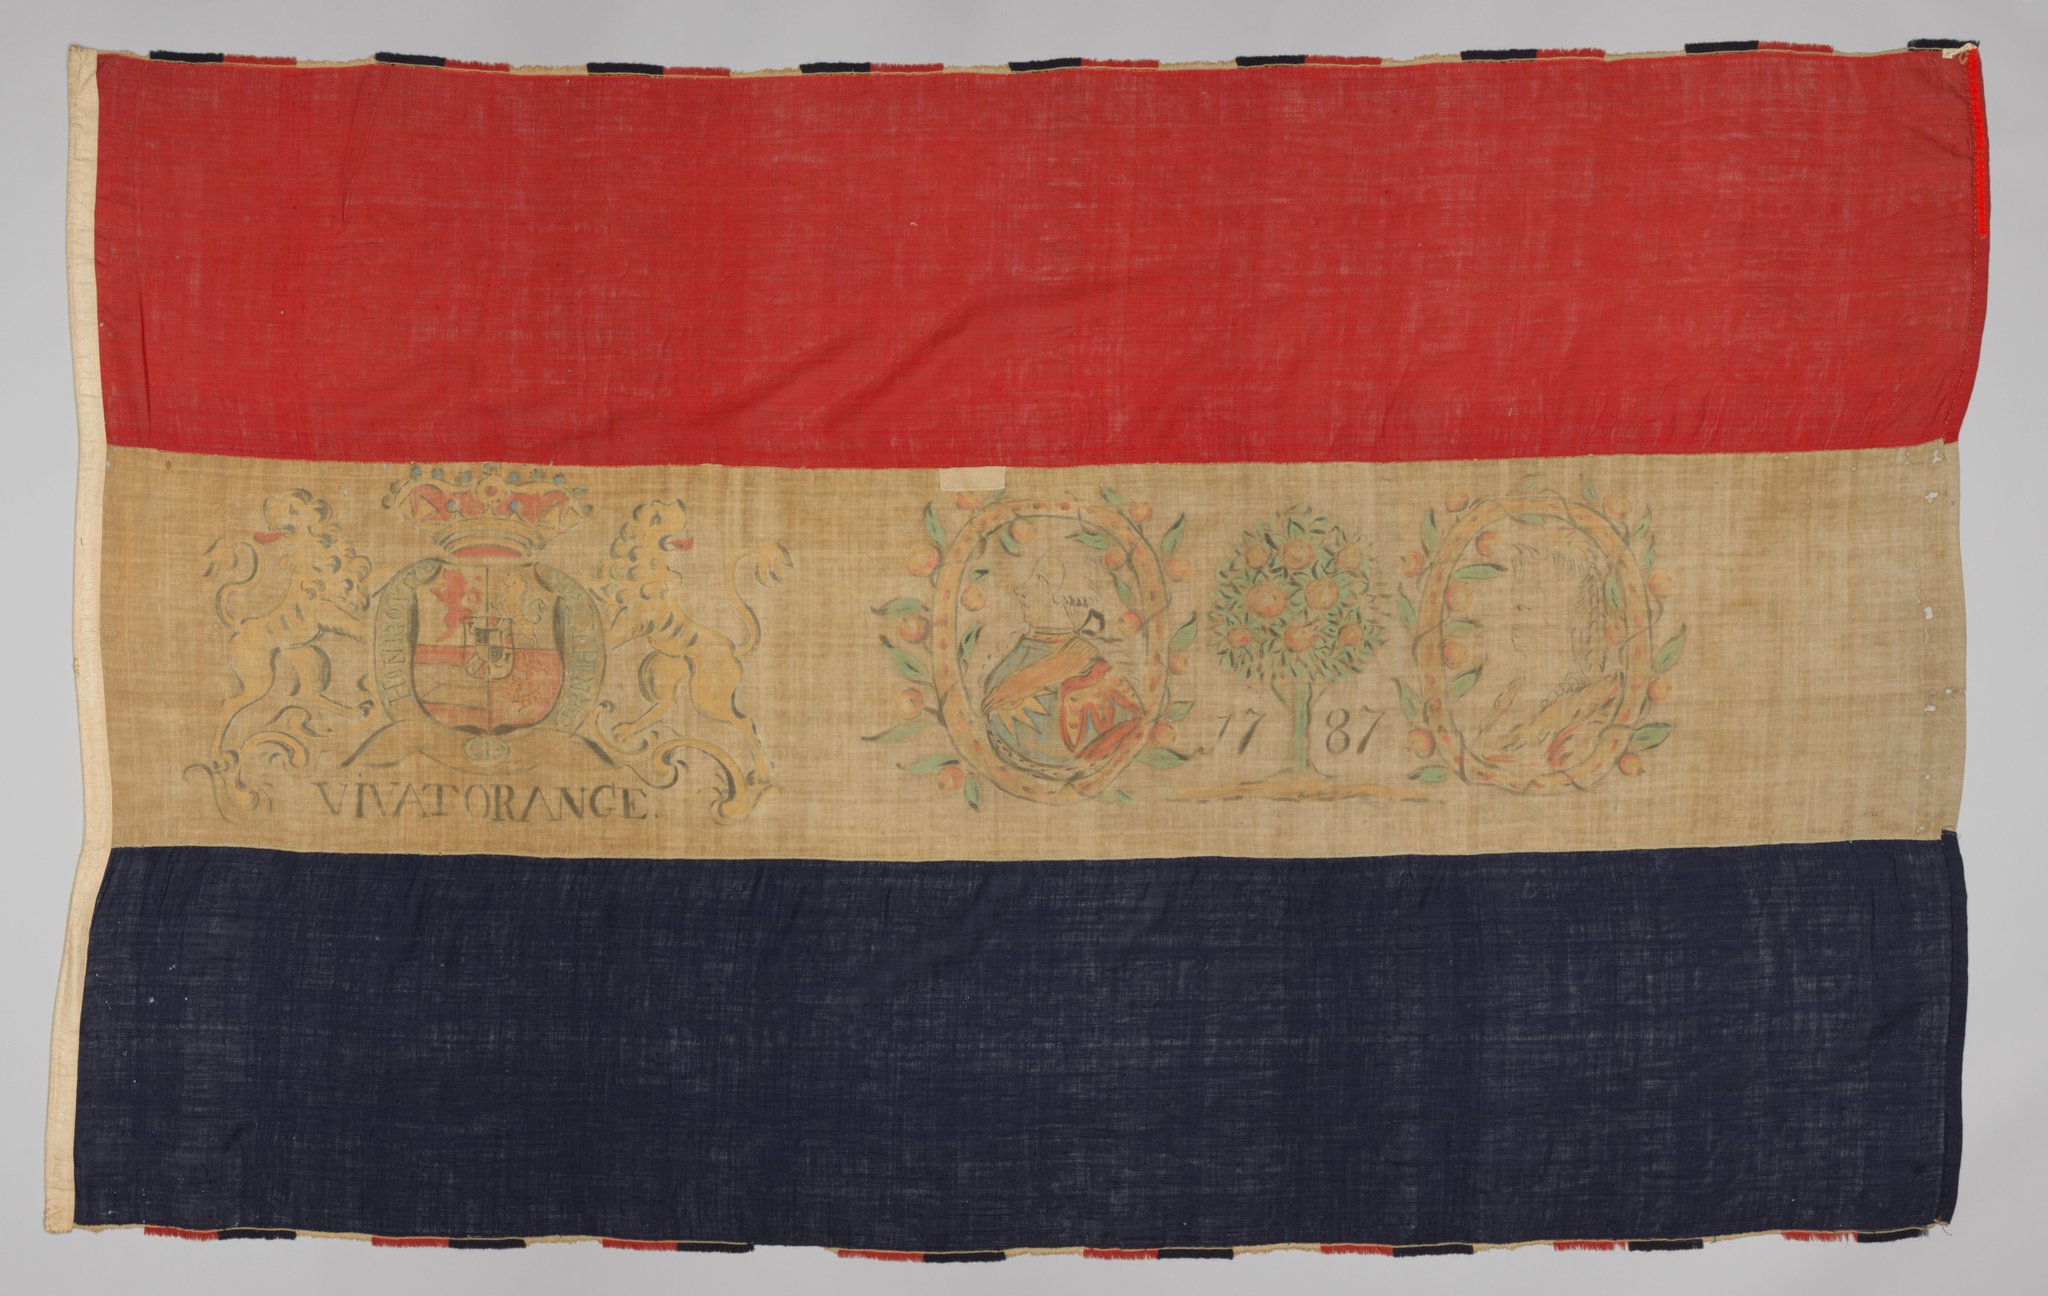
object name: flag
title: Nederlandse vlag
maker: Anonymous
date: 1787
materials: wool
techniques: painted, sewing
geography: netherlands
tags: the hague, william v (prince of orange), wilhelmina of prussia (princess of orange), netherlands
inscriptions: date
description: Banen rood-wit-blauw. de witte baan is aan de voorkant beschilderd met van broekzijde naar vluchtzijde: het gekroonde en door de Orde van de Kousenband omgeven wapen van Willem V, gehouden door twee omziende gele leeuwen, waaronder in zwarte kapitalen: VIVAT ORANGE. Daarnaast het borstbeeld van Willem V en profil van links, gevat in ovaal met enige oranjetakken eromheen. een oranjeboom groeit op bruingeel grond met aan weerskanten van de stam 17 en 87; het borstbeeld van Wilhelmina van Pruisen en profil naar links in ovaal als Willem V. Aan drie zijden omgeven met korte franje rood-wit-blauw.